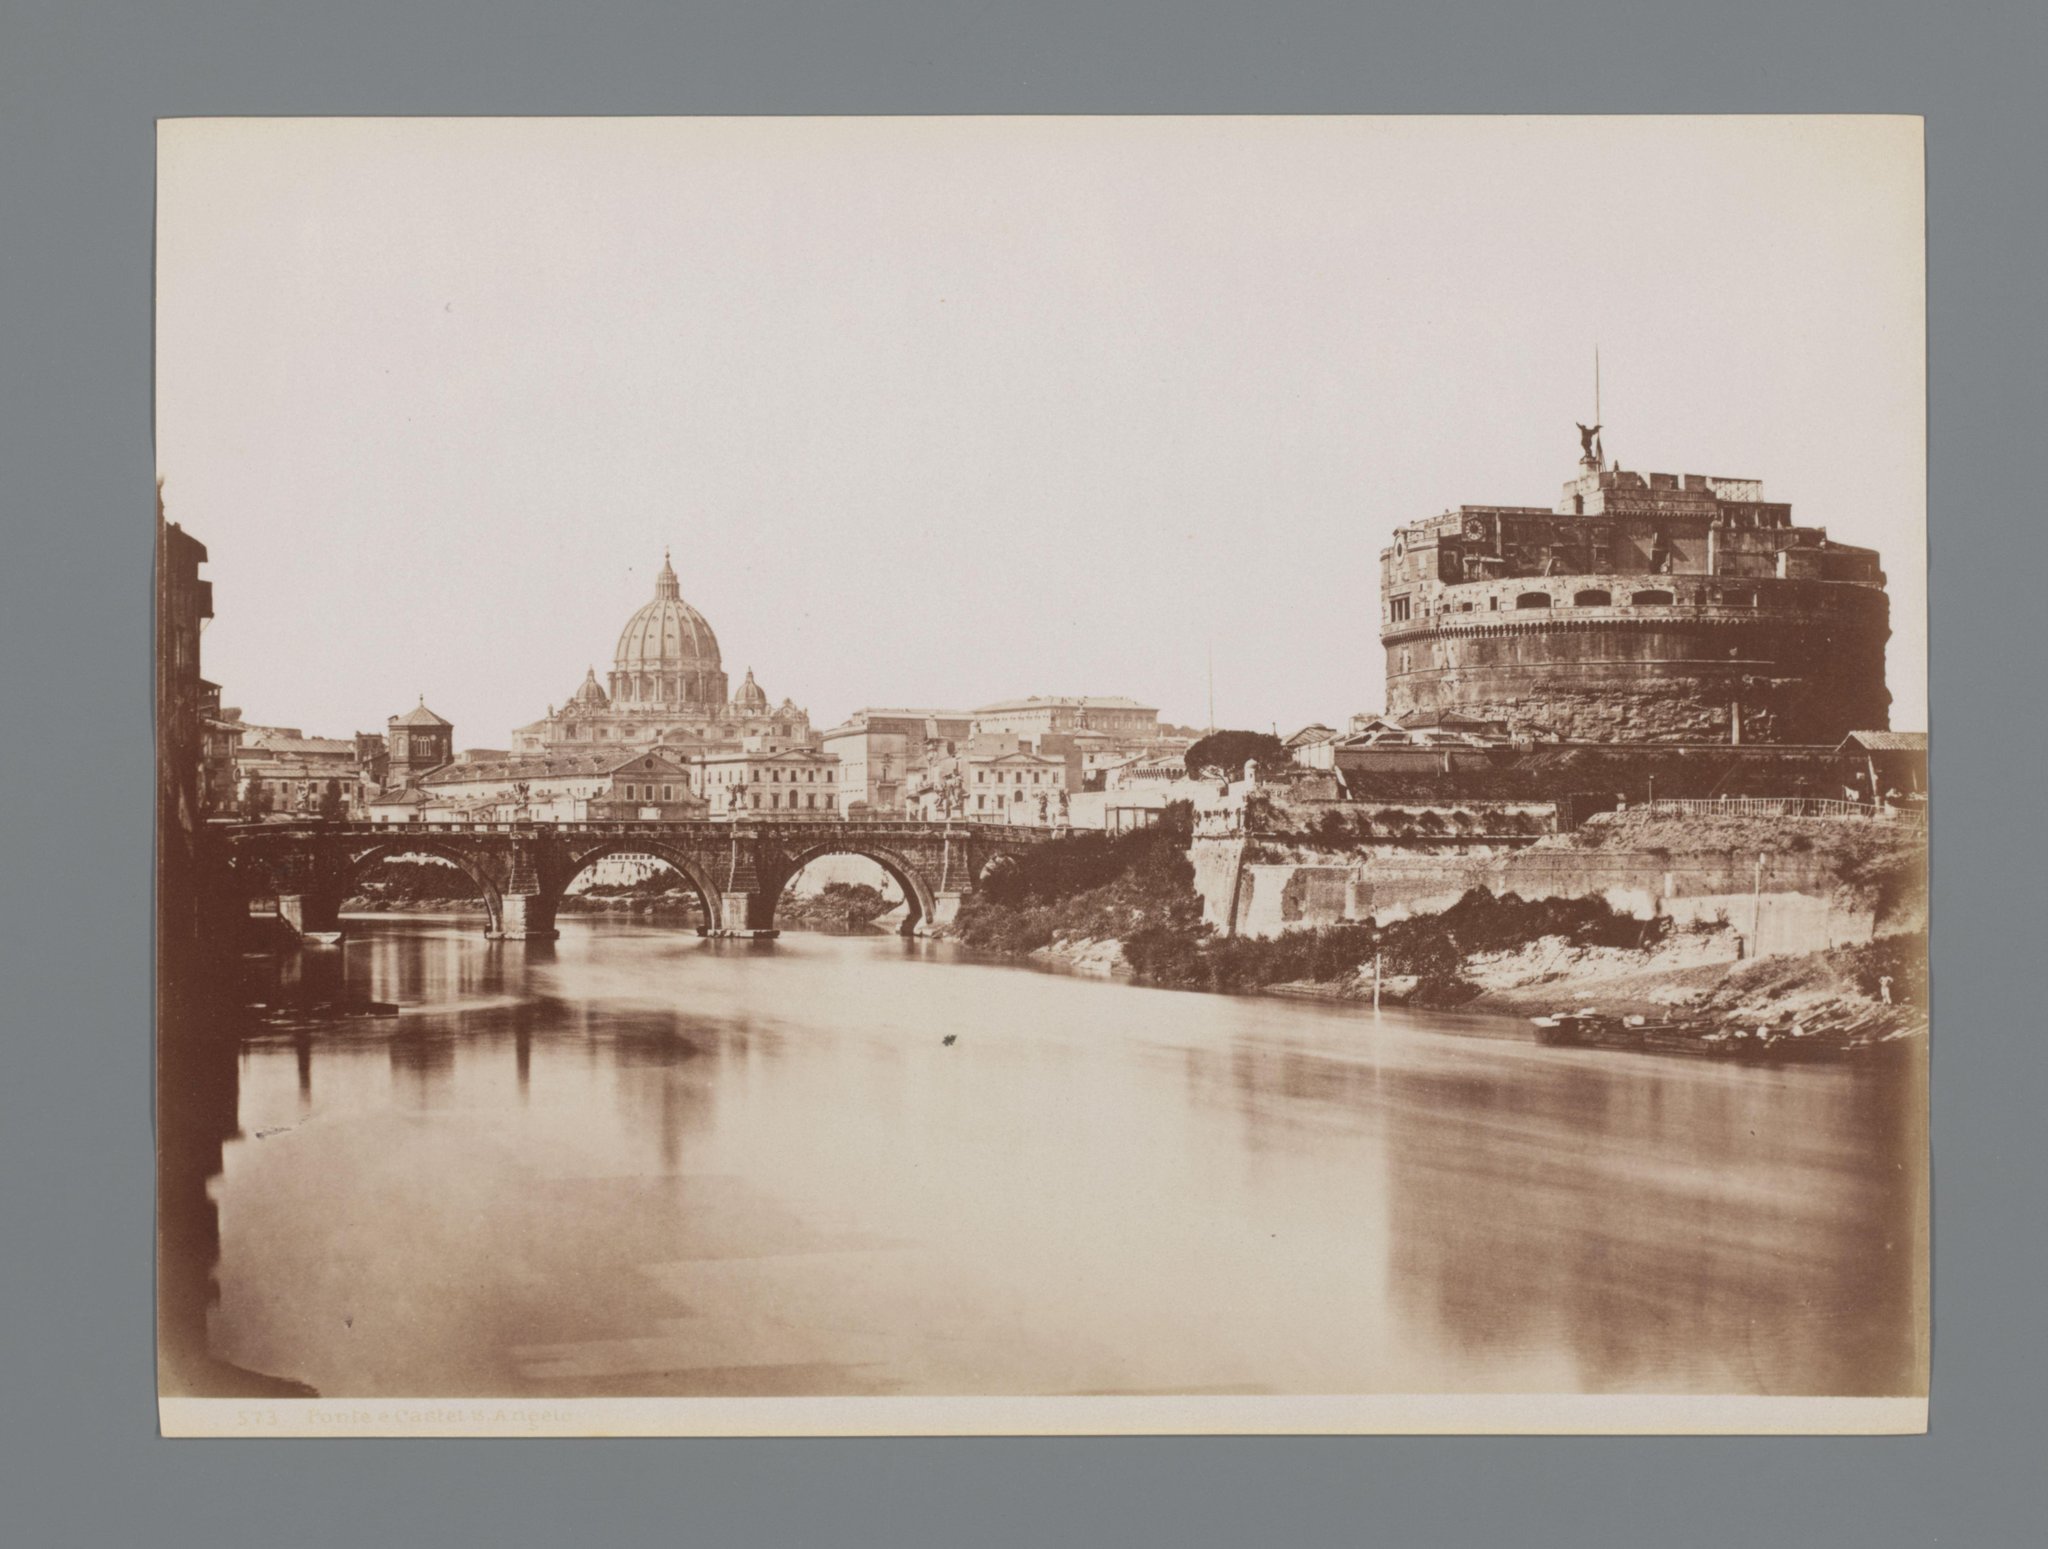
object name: photograph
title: Ponte e Castel S. Angelo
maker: james anderson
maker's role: fotograaf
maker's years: 1813-1877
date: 1851-1900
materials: paper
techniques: albumen print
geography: rome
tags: bridge in city across river, canal, etc.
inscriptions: number: ‘573.’, collector's mark: ‘VOSMAER’